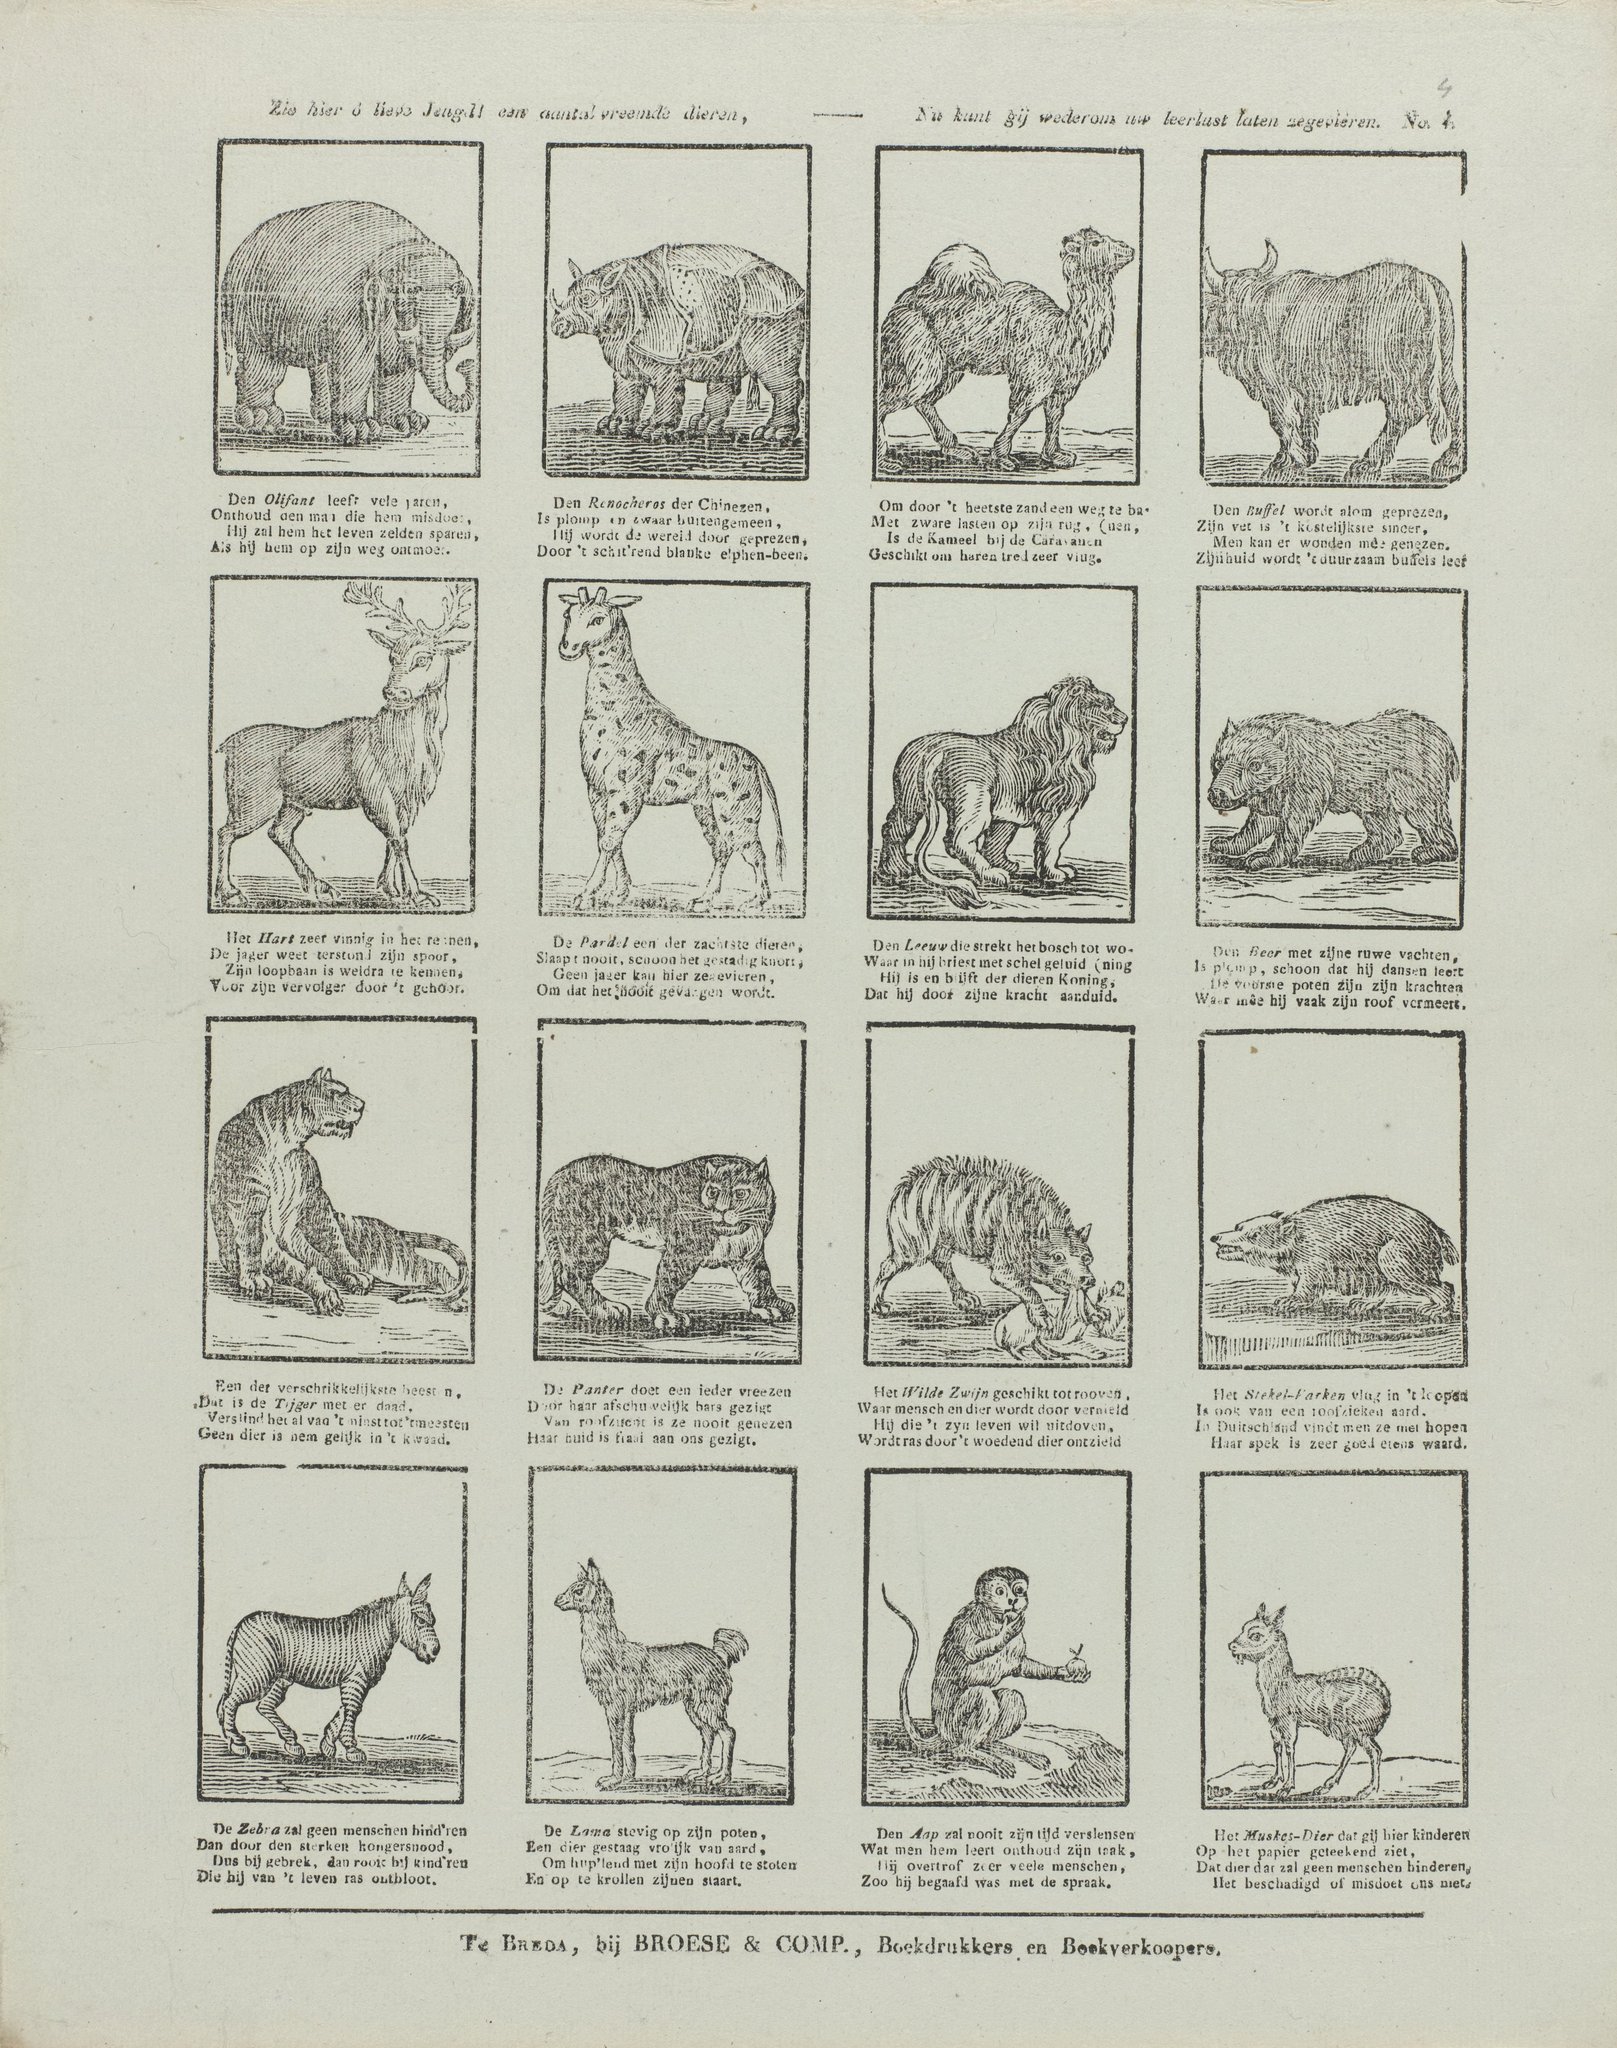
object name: popular print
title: Zie hier ô lieve jeugd! een aantal vreemde dieren, - Nu kunt gij wederom uw leerlust laten zegevieren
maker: Anonymous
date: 1828-1853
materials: paper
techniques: letterpress printing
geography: breda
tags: hoofed animals: camel, monkeys, apes, hoofed animals: rhinoceros, hoofed animals: giraffe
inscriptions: collector's mark: Lugt 2760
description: Blad met 16 voorstellingen van wilde dieren, waaronder een neushoorn, een kameel, een giraf en een aap. Onder elke voorstelling een vierregelig vers. Genummerd rechtsboven: No. 4.